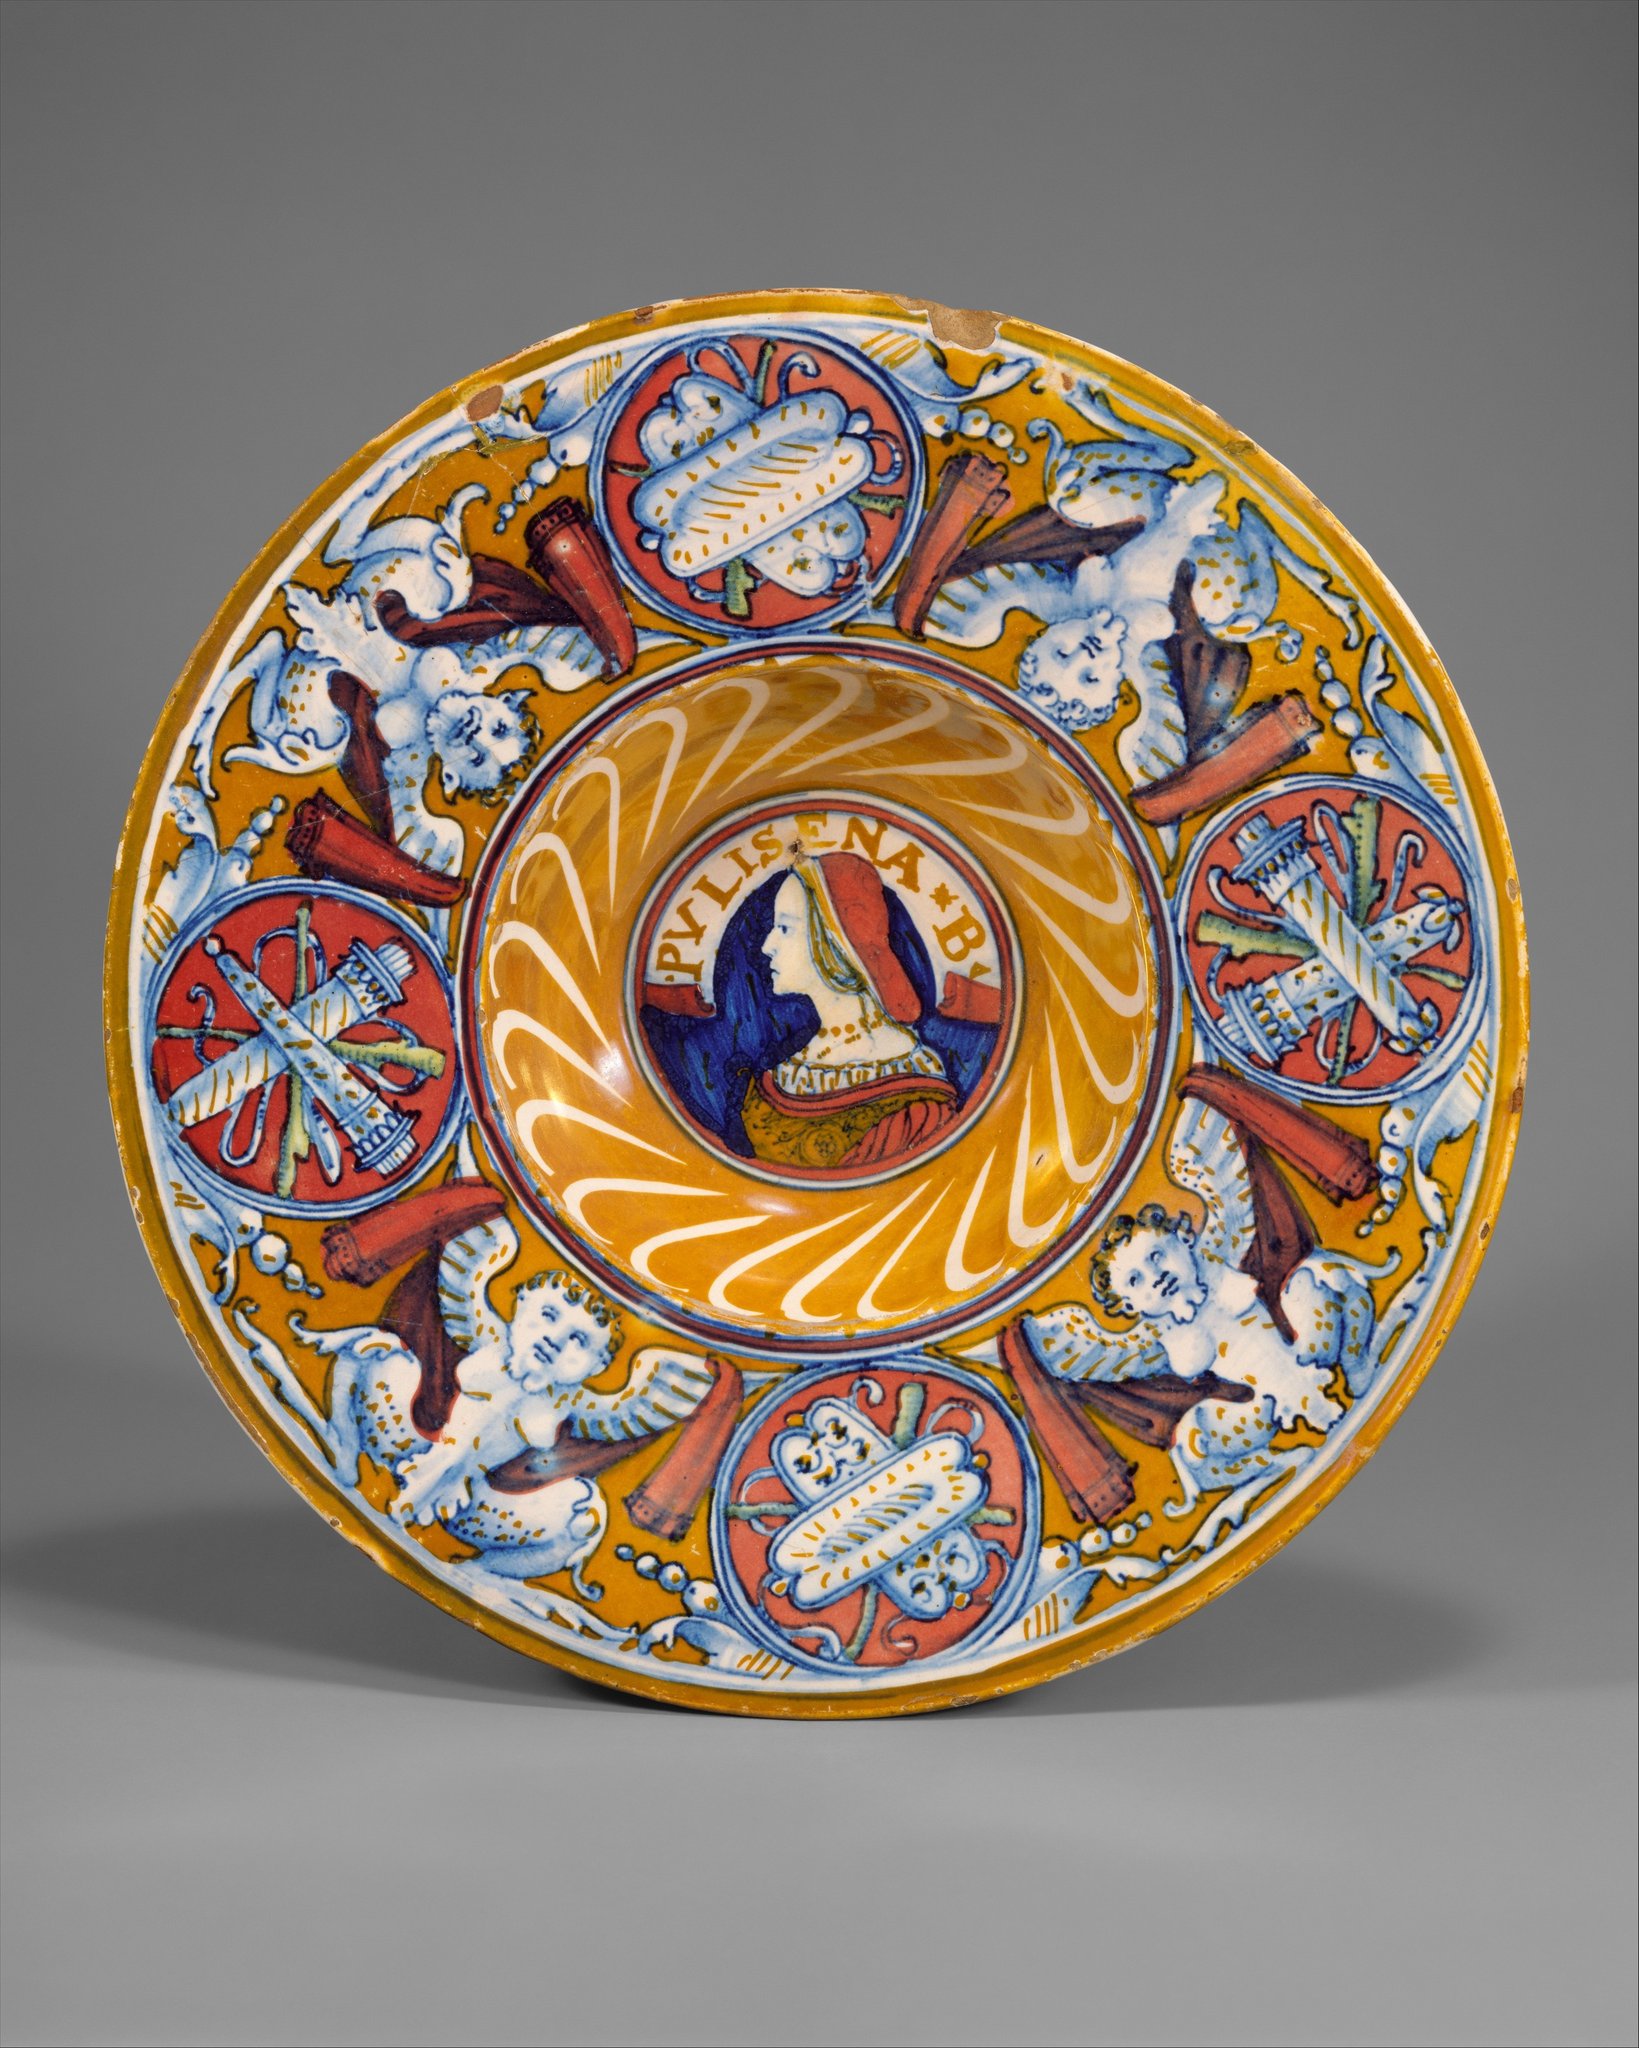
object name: plate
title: Plate (tondino)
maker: maestro giorgio andreoli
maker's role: artist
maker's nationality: italian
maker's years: 1500-1550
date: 1519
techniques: maiolica, glazing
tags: women